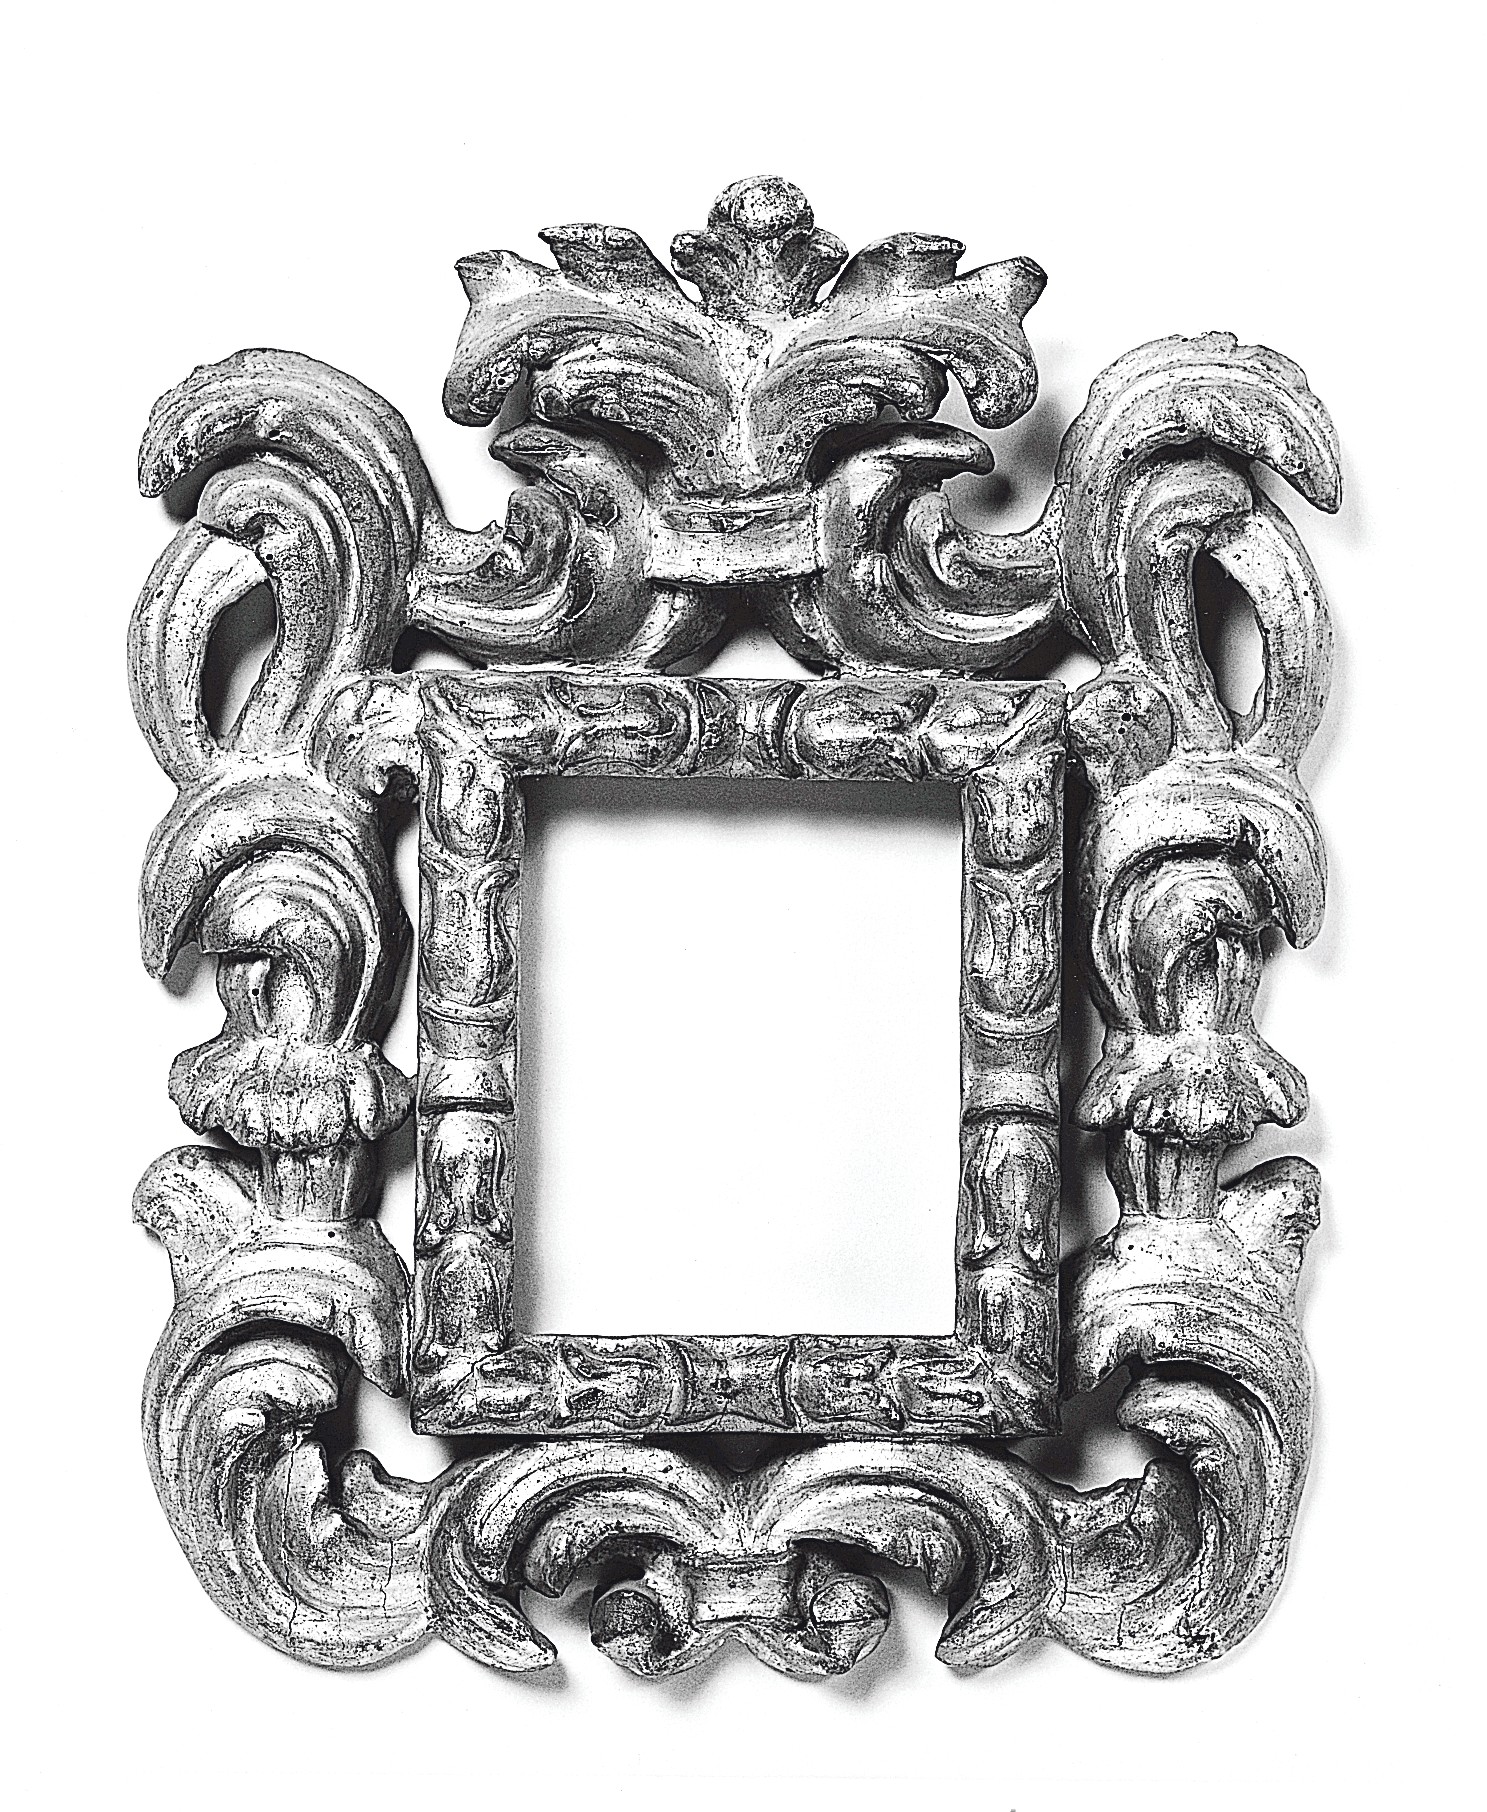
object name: frame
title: Cauliculi frame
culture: italian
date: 1701-1733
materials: wood